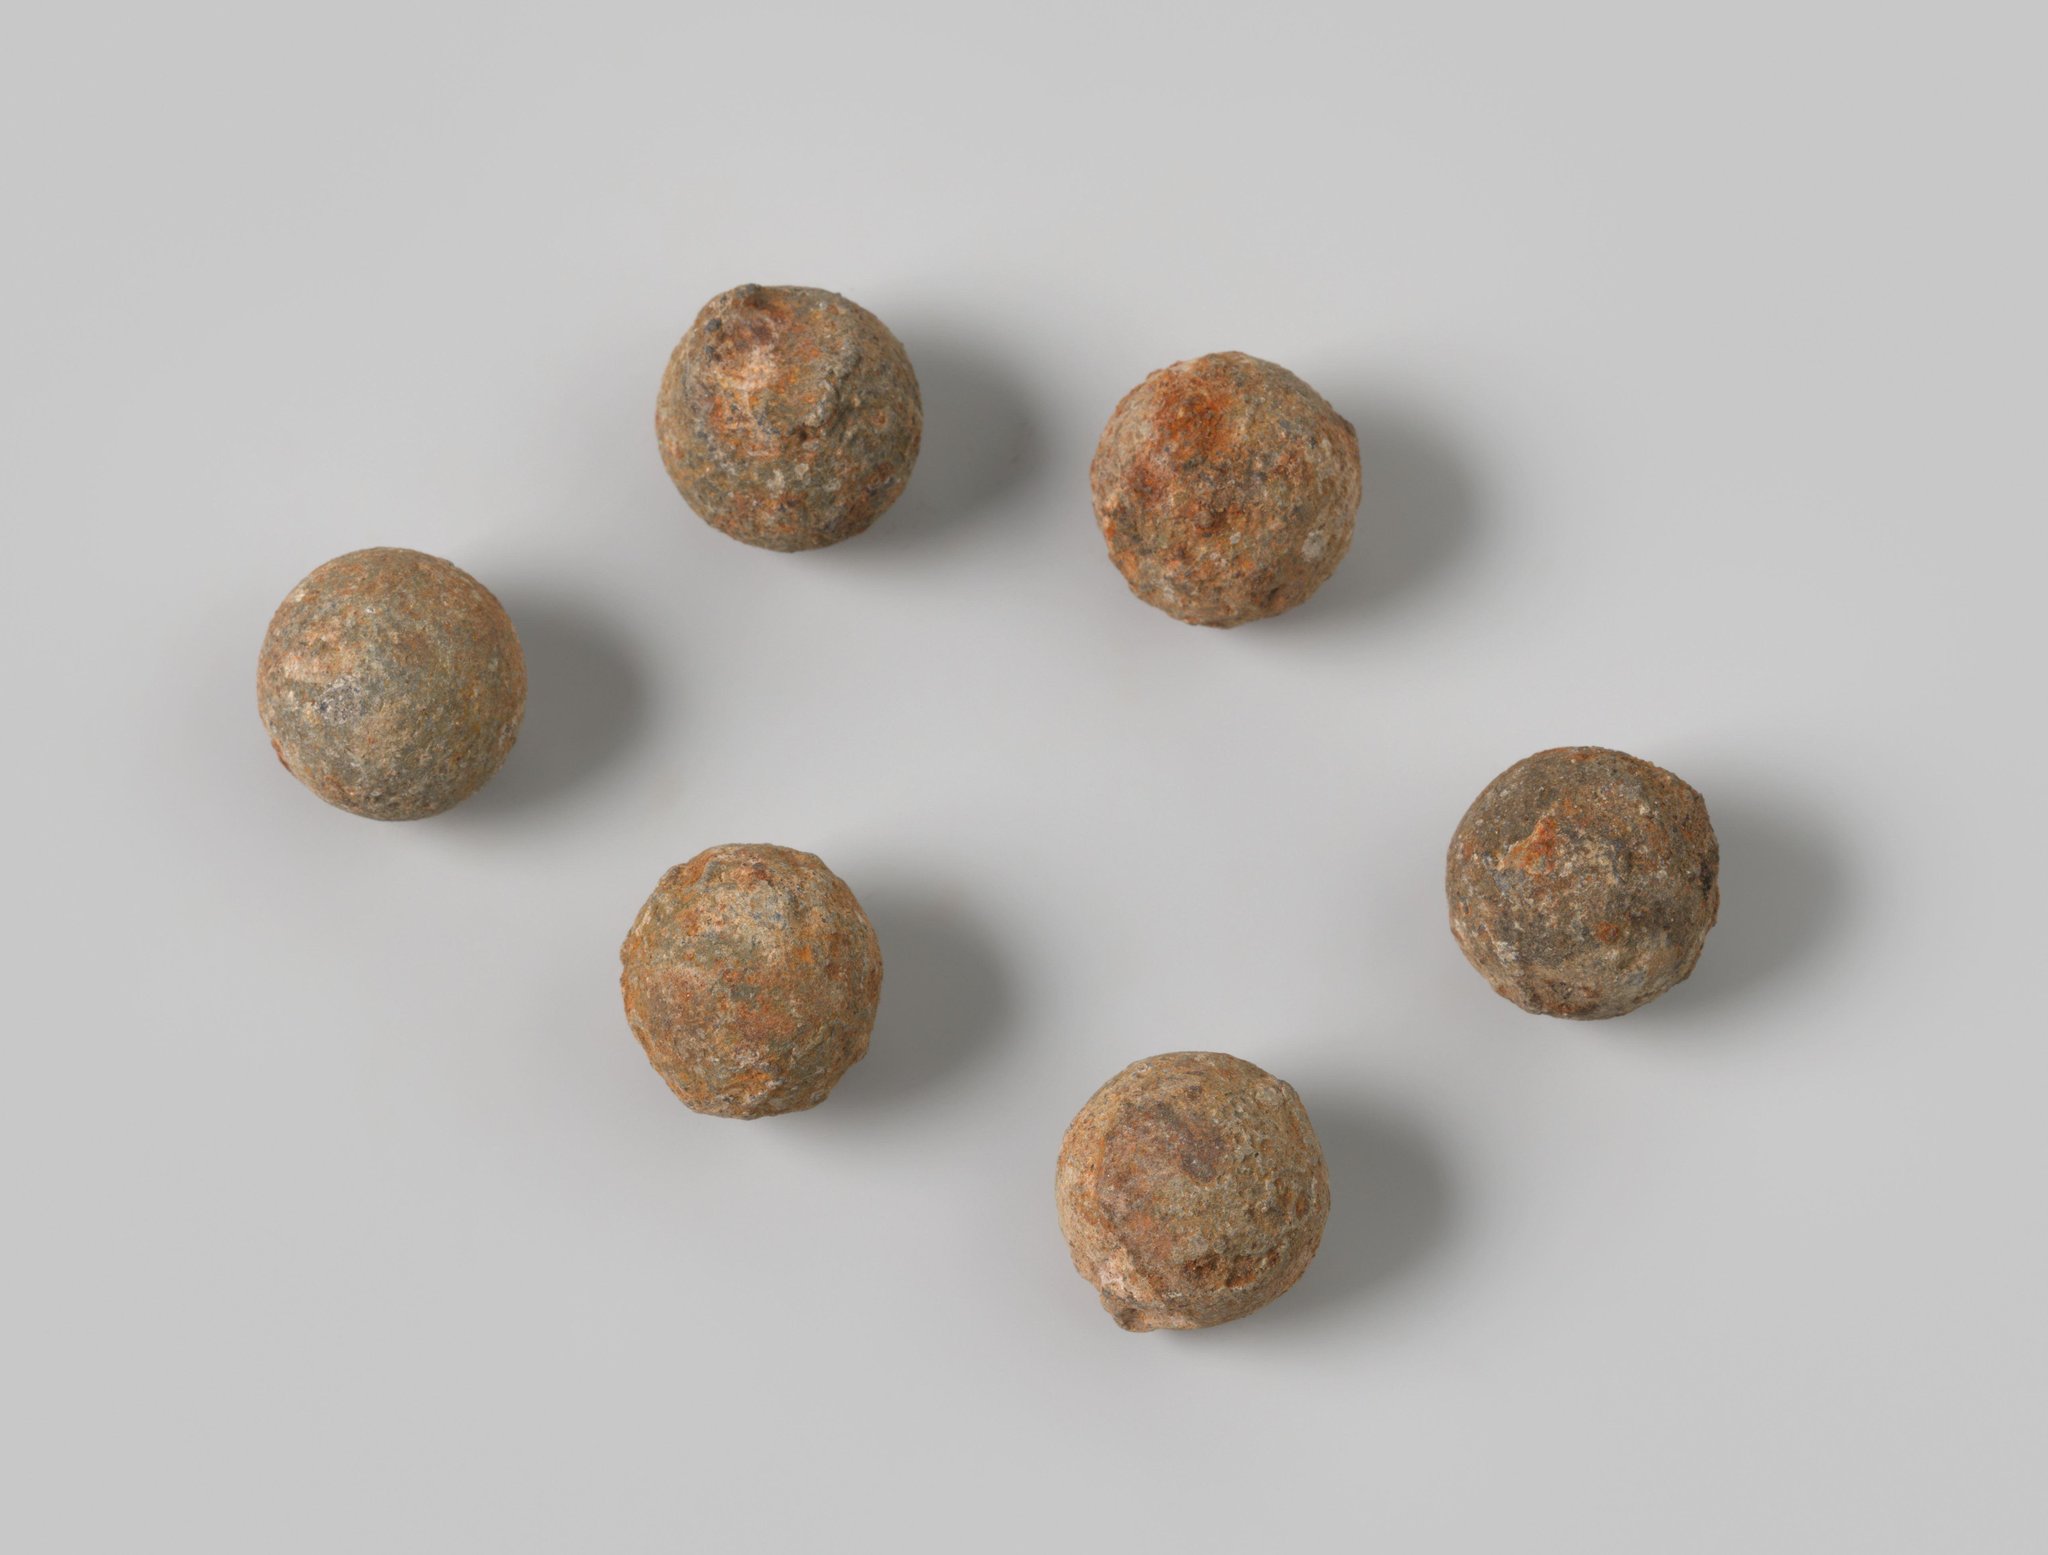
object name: musketkogel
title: Musketkogels uit het wrak van de Oost-Indiëvaarder Hollandia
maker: Anonymous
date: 1700-1743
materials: lead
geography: netherlands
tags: verenigde oostindische compagnie, hollandia (schip), annet